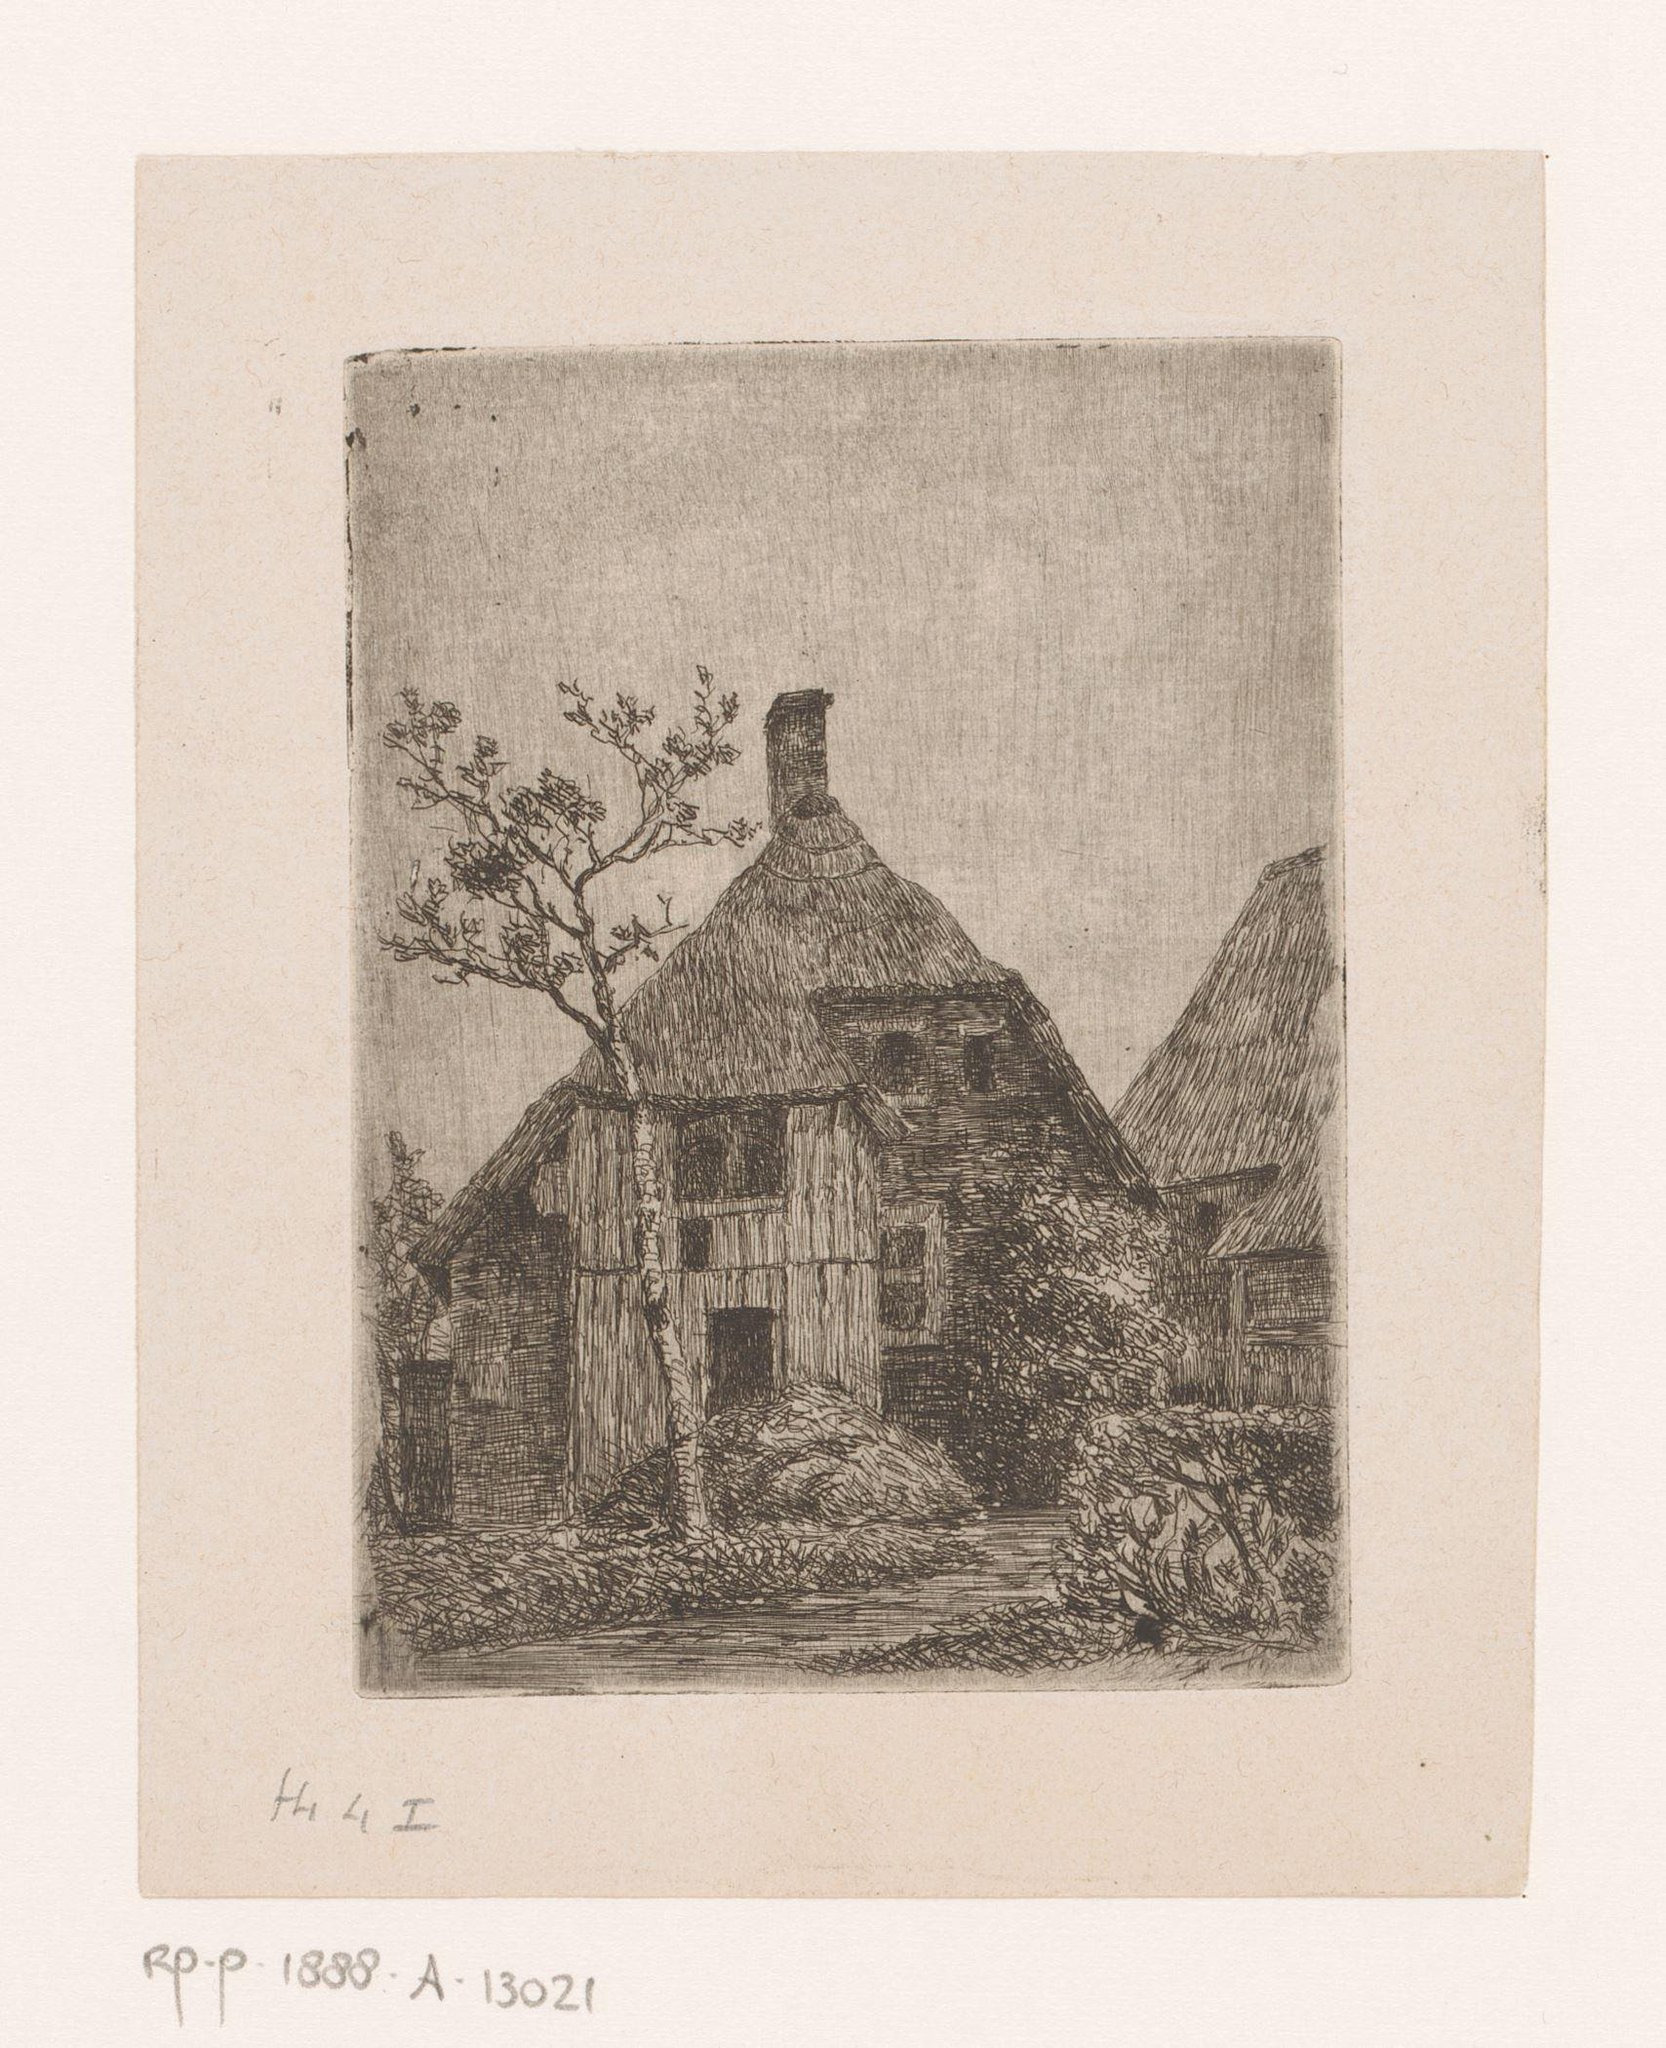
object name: print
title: Gezicht op een rietgedekte hoeve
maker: jean pierre françois lamorinière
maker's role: print maker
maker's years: 1828-1911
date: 1838-1888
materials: paper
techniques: etching, intaglio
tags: farm or solitary house in landscape, farm (building)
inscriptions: collector's mark: Lugt 2228